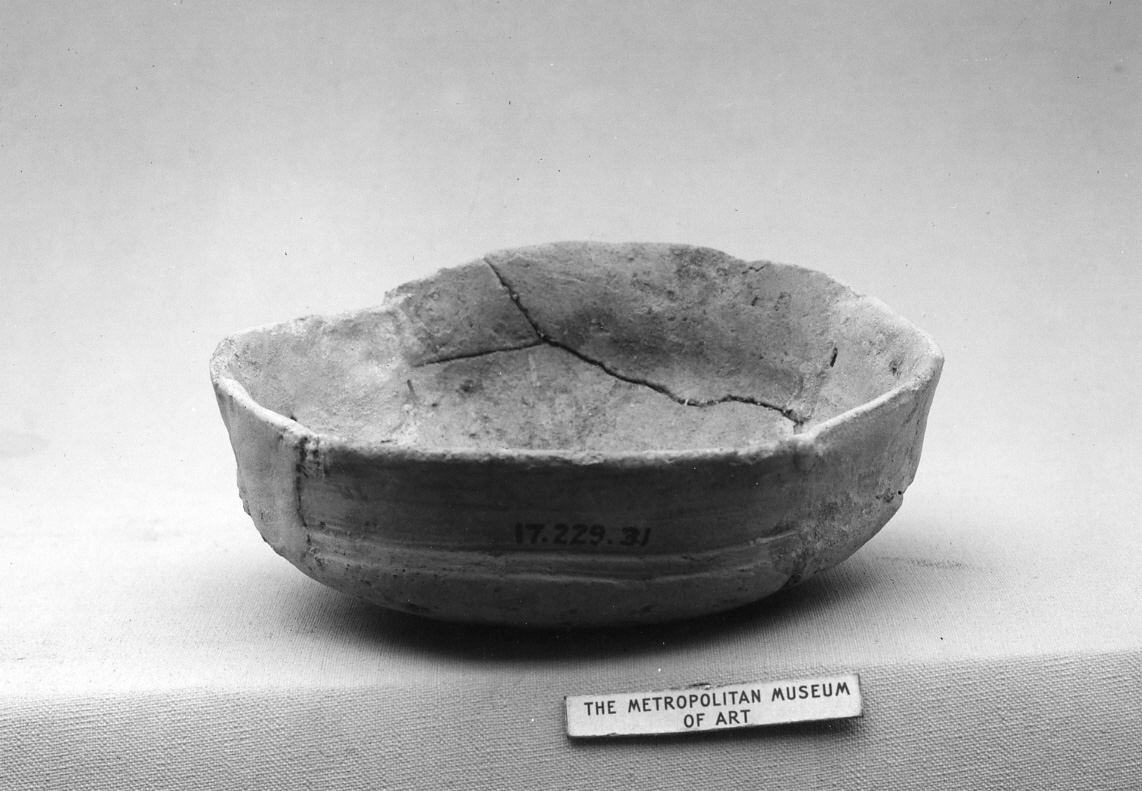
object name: haniwa dish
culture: japanese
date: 301-700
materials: earthenware